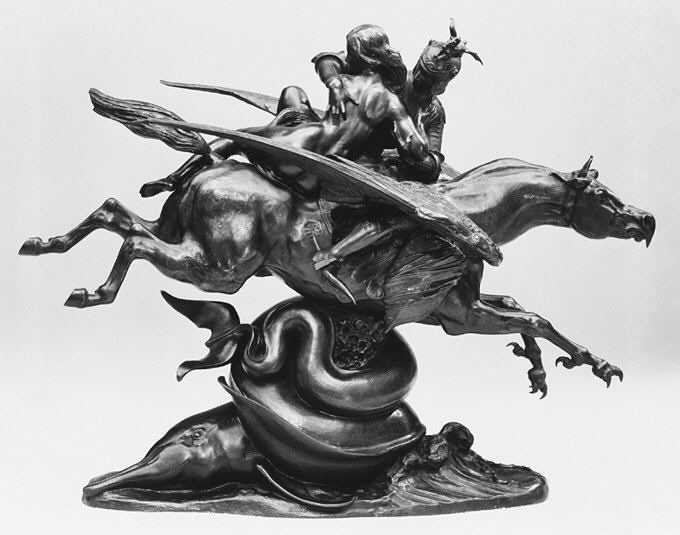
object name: statuette group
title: Roger and Angelica Mounted on a Hippogriff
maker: antoine-louis barye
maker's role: artist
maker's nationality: french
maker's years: 1795-1875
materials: bronze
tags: men,women,mythical creatures,dolphins